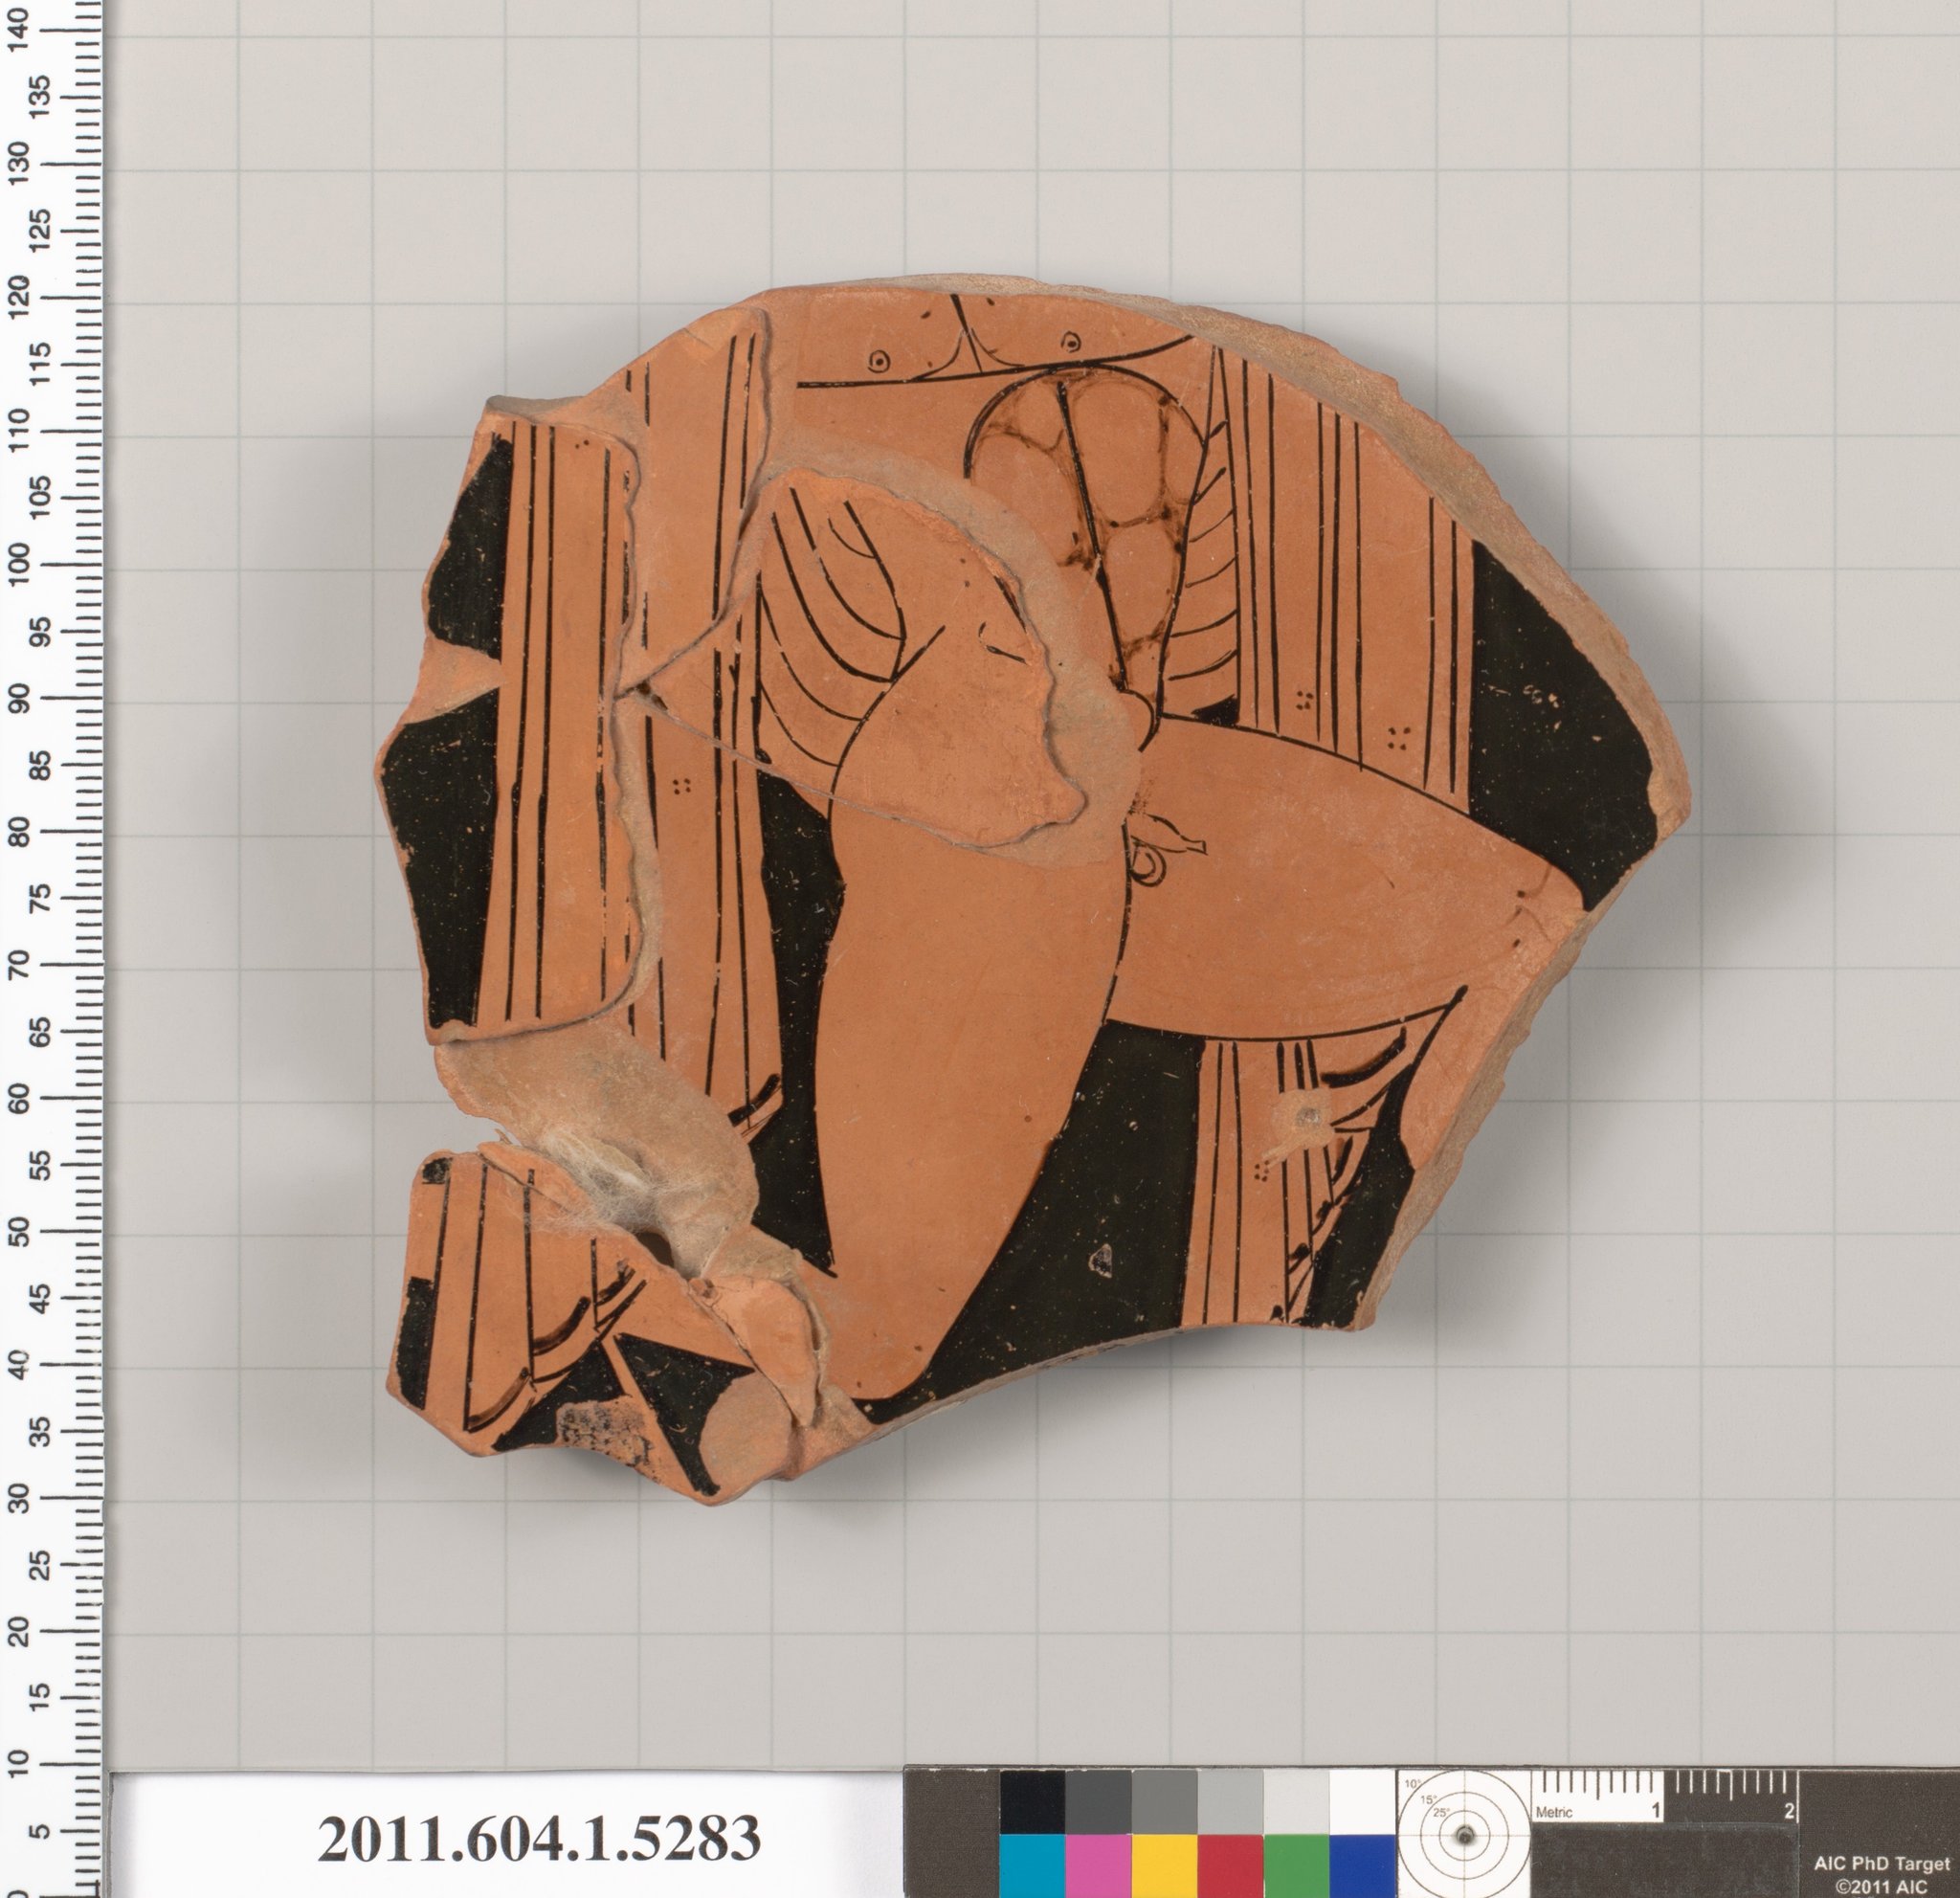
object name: kylix fragment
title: Terracotta fragment of a kylix (drinking cup)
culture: greek, attic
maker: h.p. painter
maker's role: artist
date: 510-490 BCE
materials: terracotta